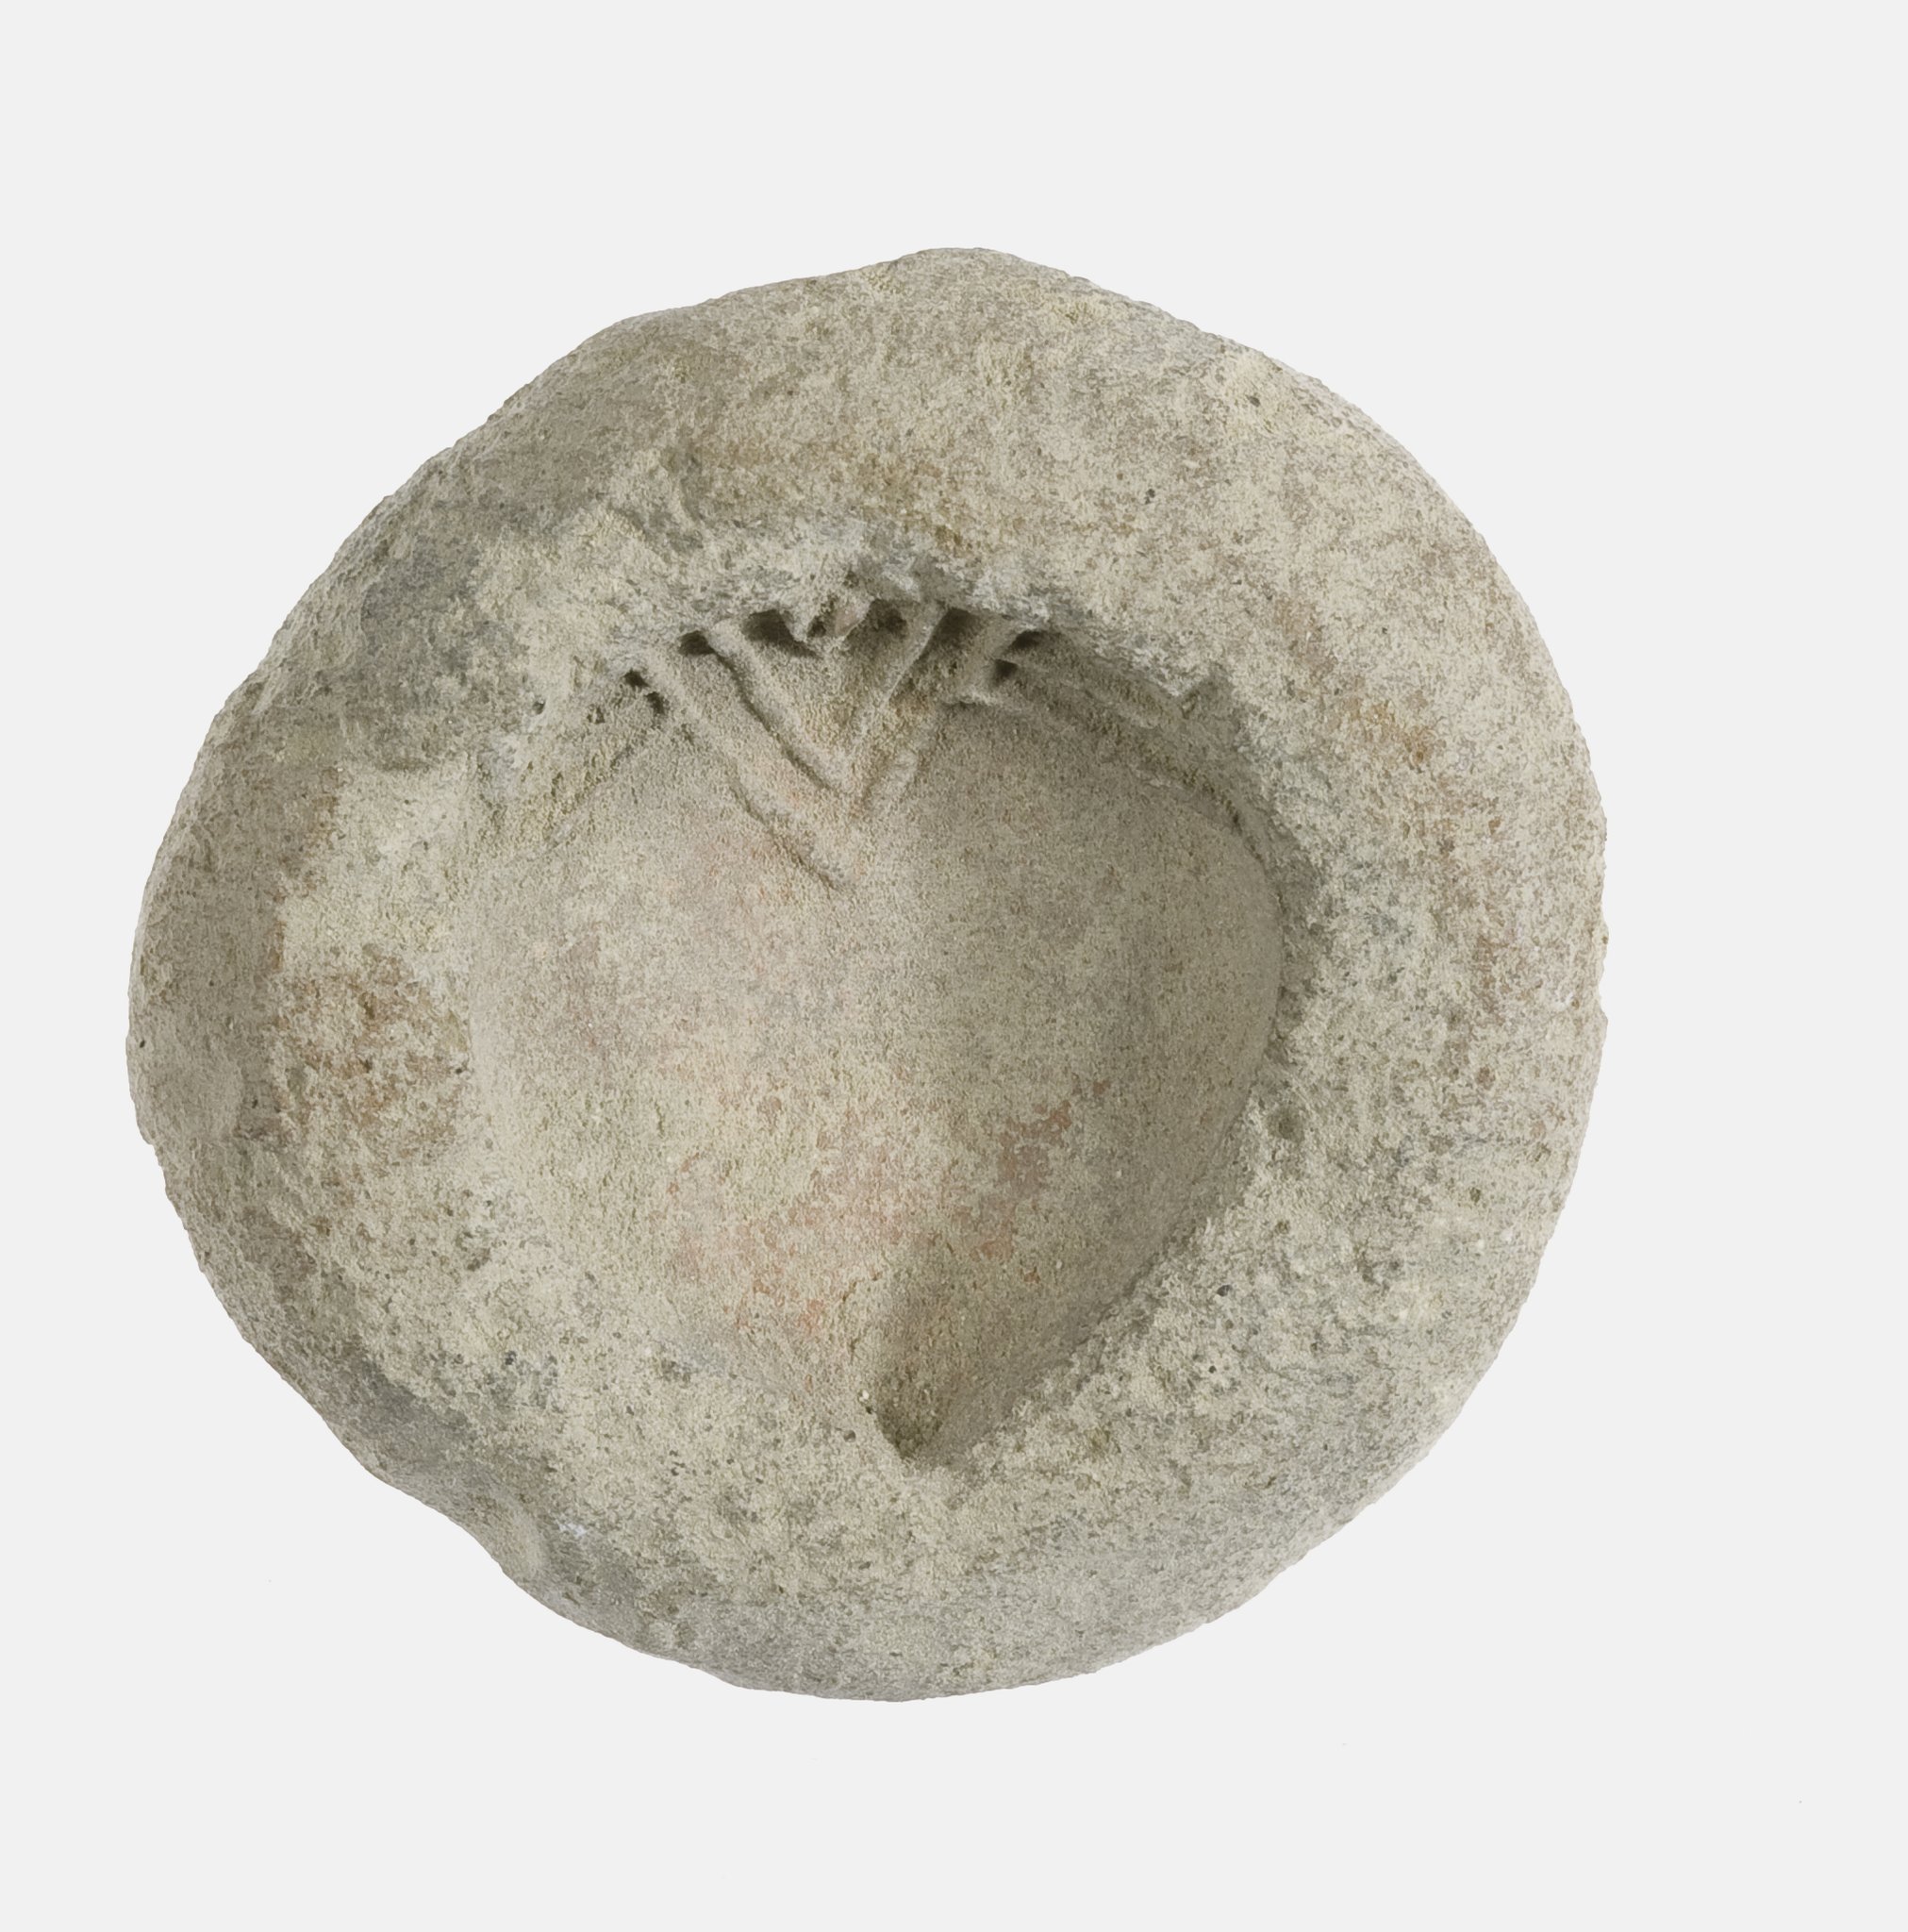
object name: mold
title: Persia Fruit Mold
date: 1390-1352 BCE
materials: pottery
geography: egypt